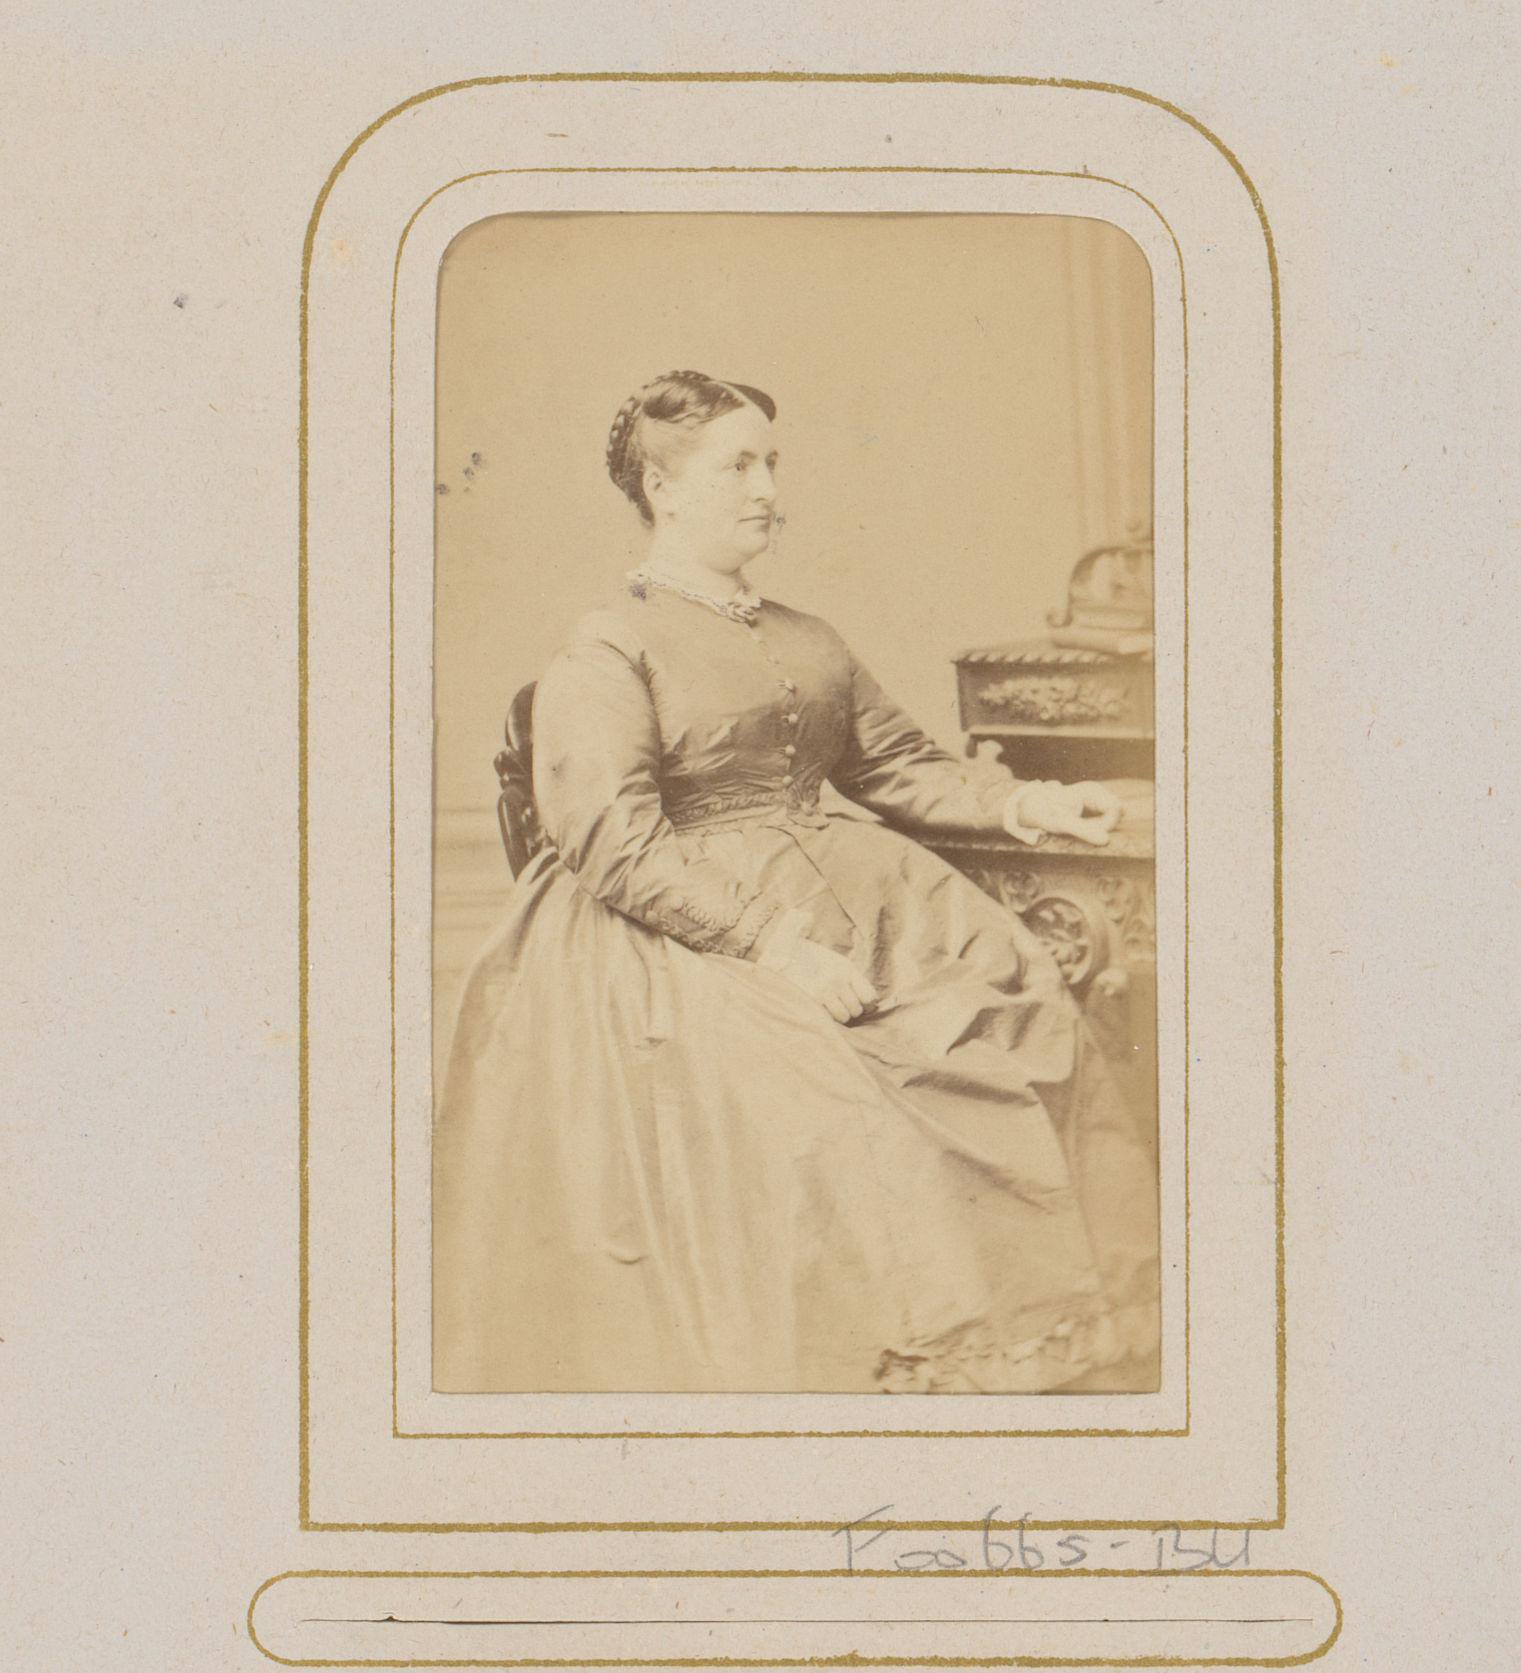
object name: album leaf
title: Portret van een vrouw bij een bureau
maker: gerarda henriëtte matthijssen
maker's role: draughtsman, painter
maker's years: 1830-1907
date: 1855-1880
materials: cardboard, photographic support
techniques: albumen print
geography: leeuwarden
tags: historical persons - bb - woman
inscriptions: inscription: ‘Gerharda H. Matthijssen/ Photographe/ Leeuwarden/ Naauw H.46 en St. Jacobstraat H 50’